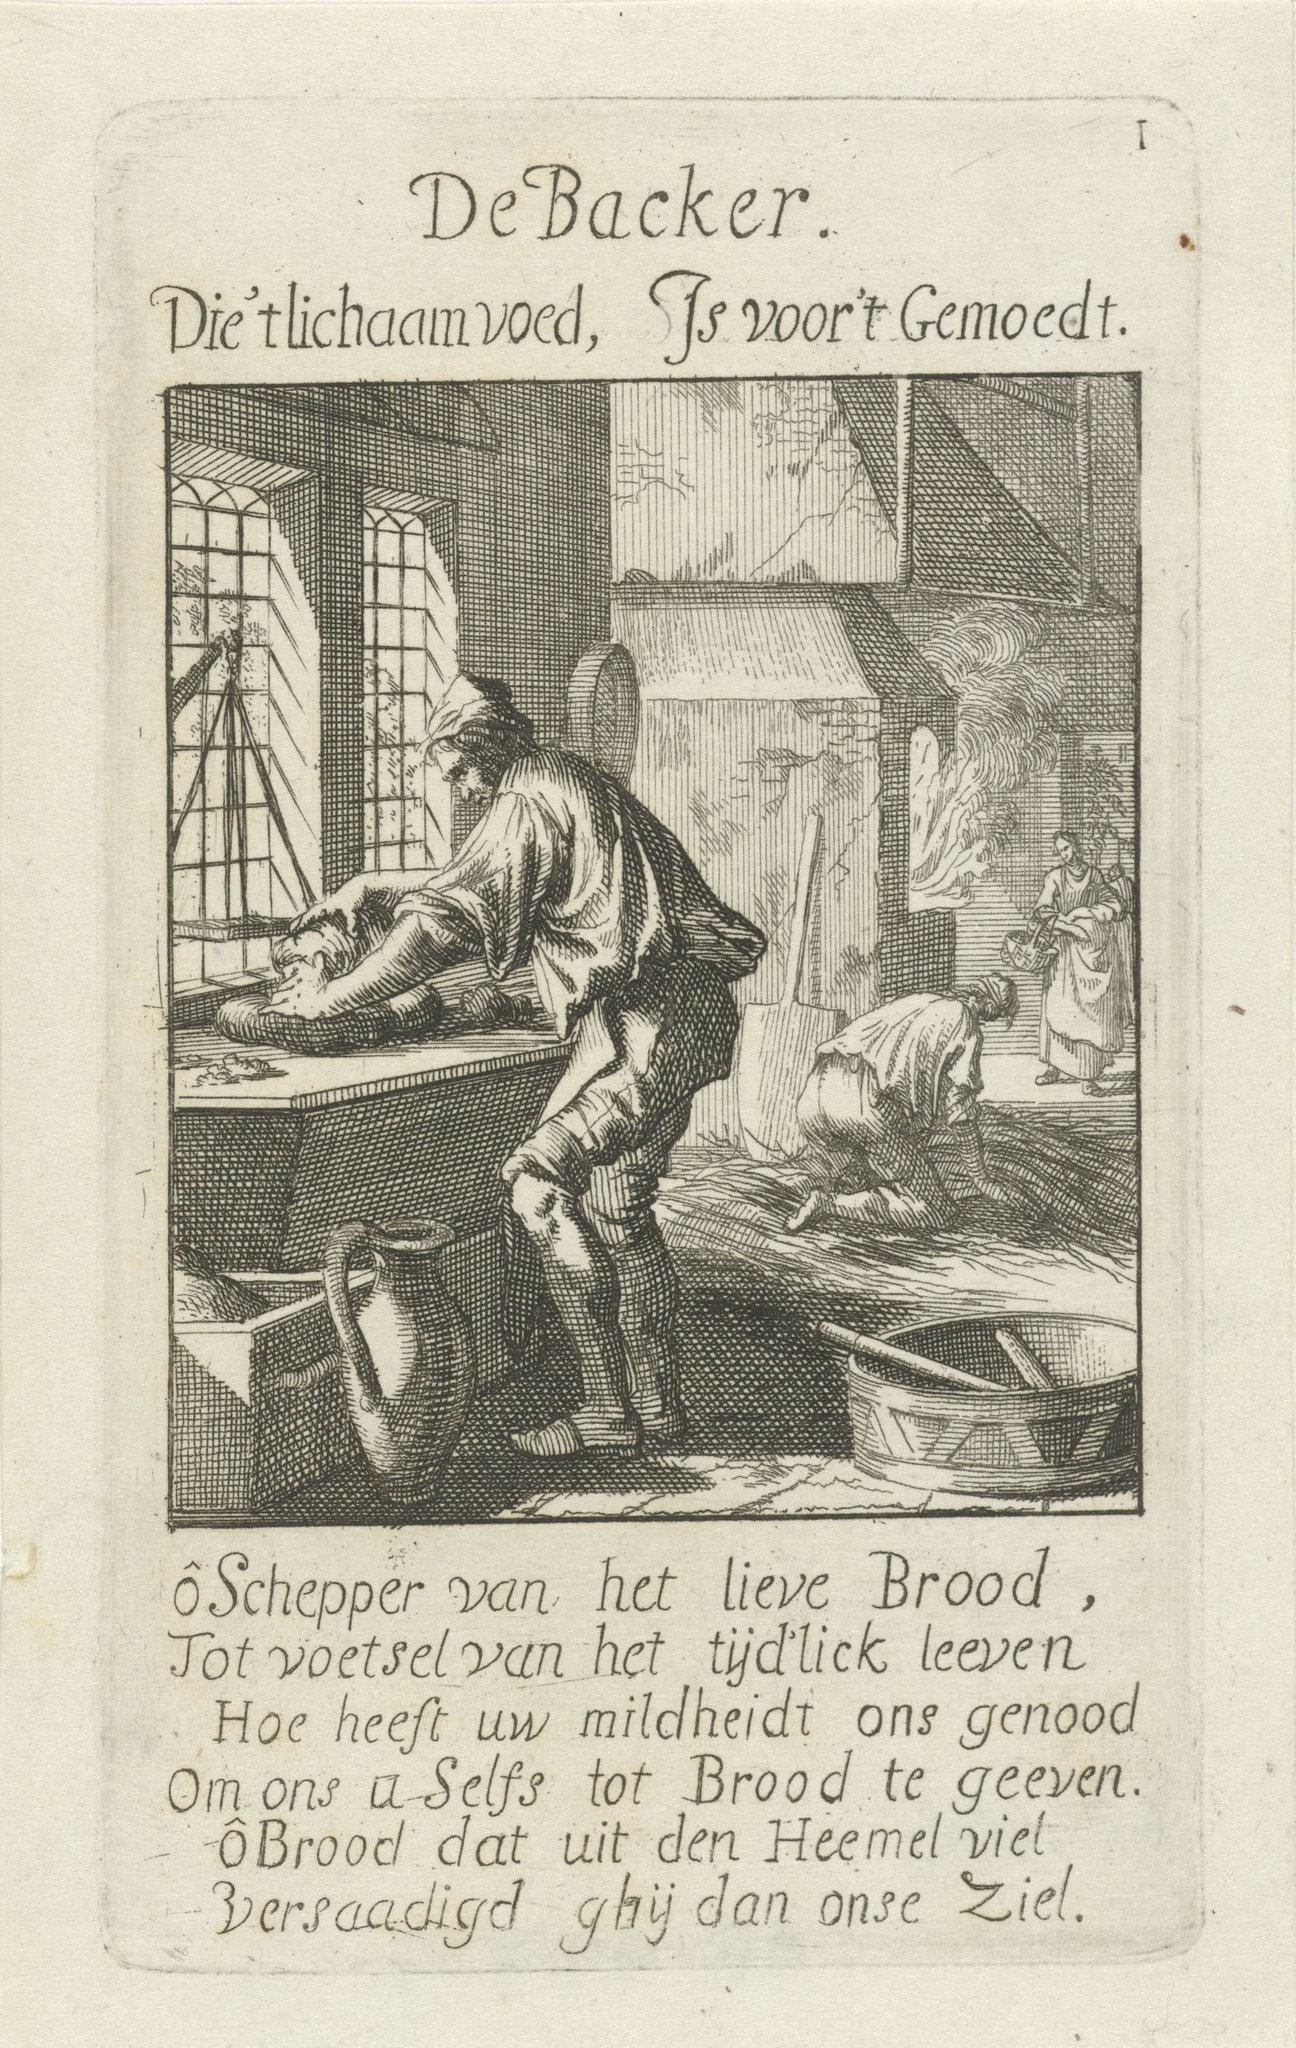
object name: print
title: Bakker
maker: jan luyken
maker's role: draughtsman, print maker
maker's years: 1649-1712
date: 1694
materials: paper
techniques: etching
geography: amsterdam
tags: handicrafts, craftsman at work, baker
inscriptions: collector's mark: Lugt 2228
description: Maakt deel uit van de 100-delige serie beroepsprenten van Jan en Caspar Luyken, getiteld: Het menselyk bedryf. S.l.s.n., 1694 (eerste druk).